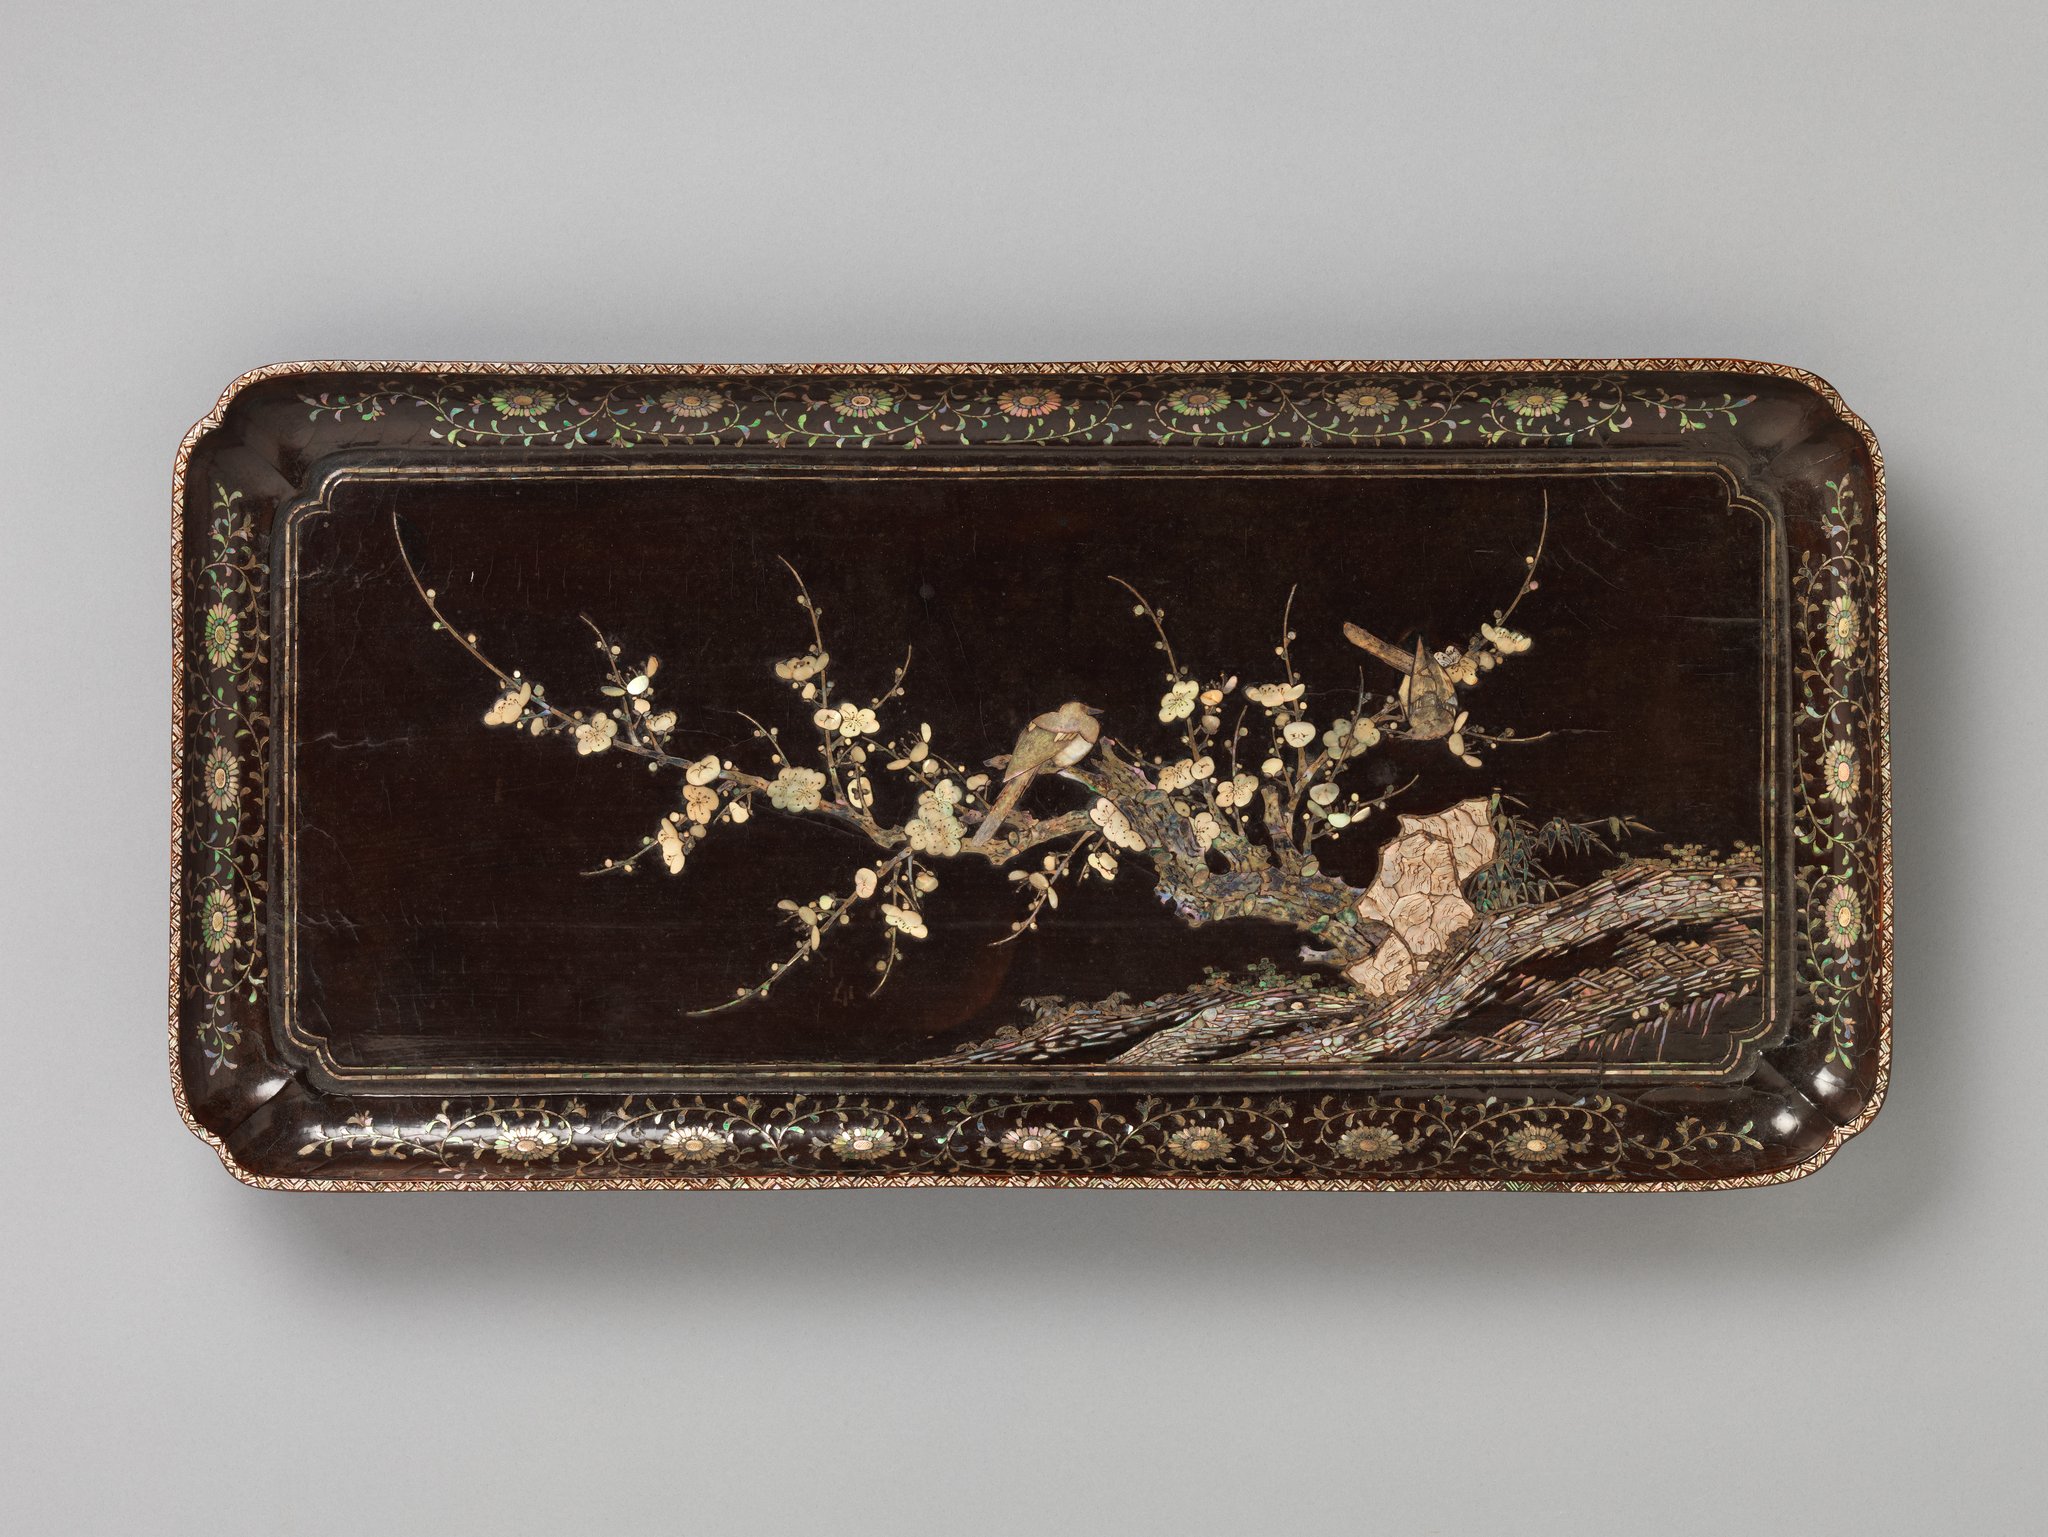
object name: tray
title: Rectangular tray with flowering plums and birds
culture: chinese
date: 1301-1400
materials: lacquer, mother of pearl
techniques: inlay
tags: birds,flowers,trees